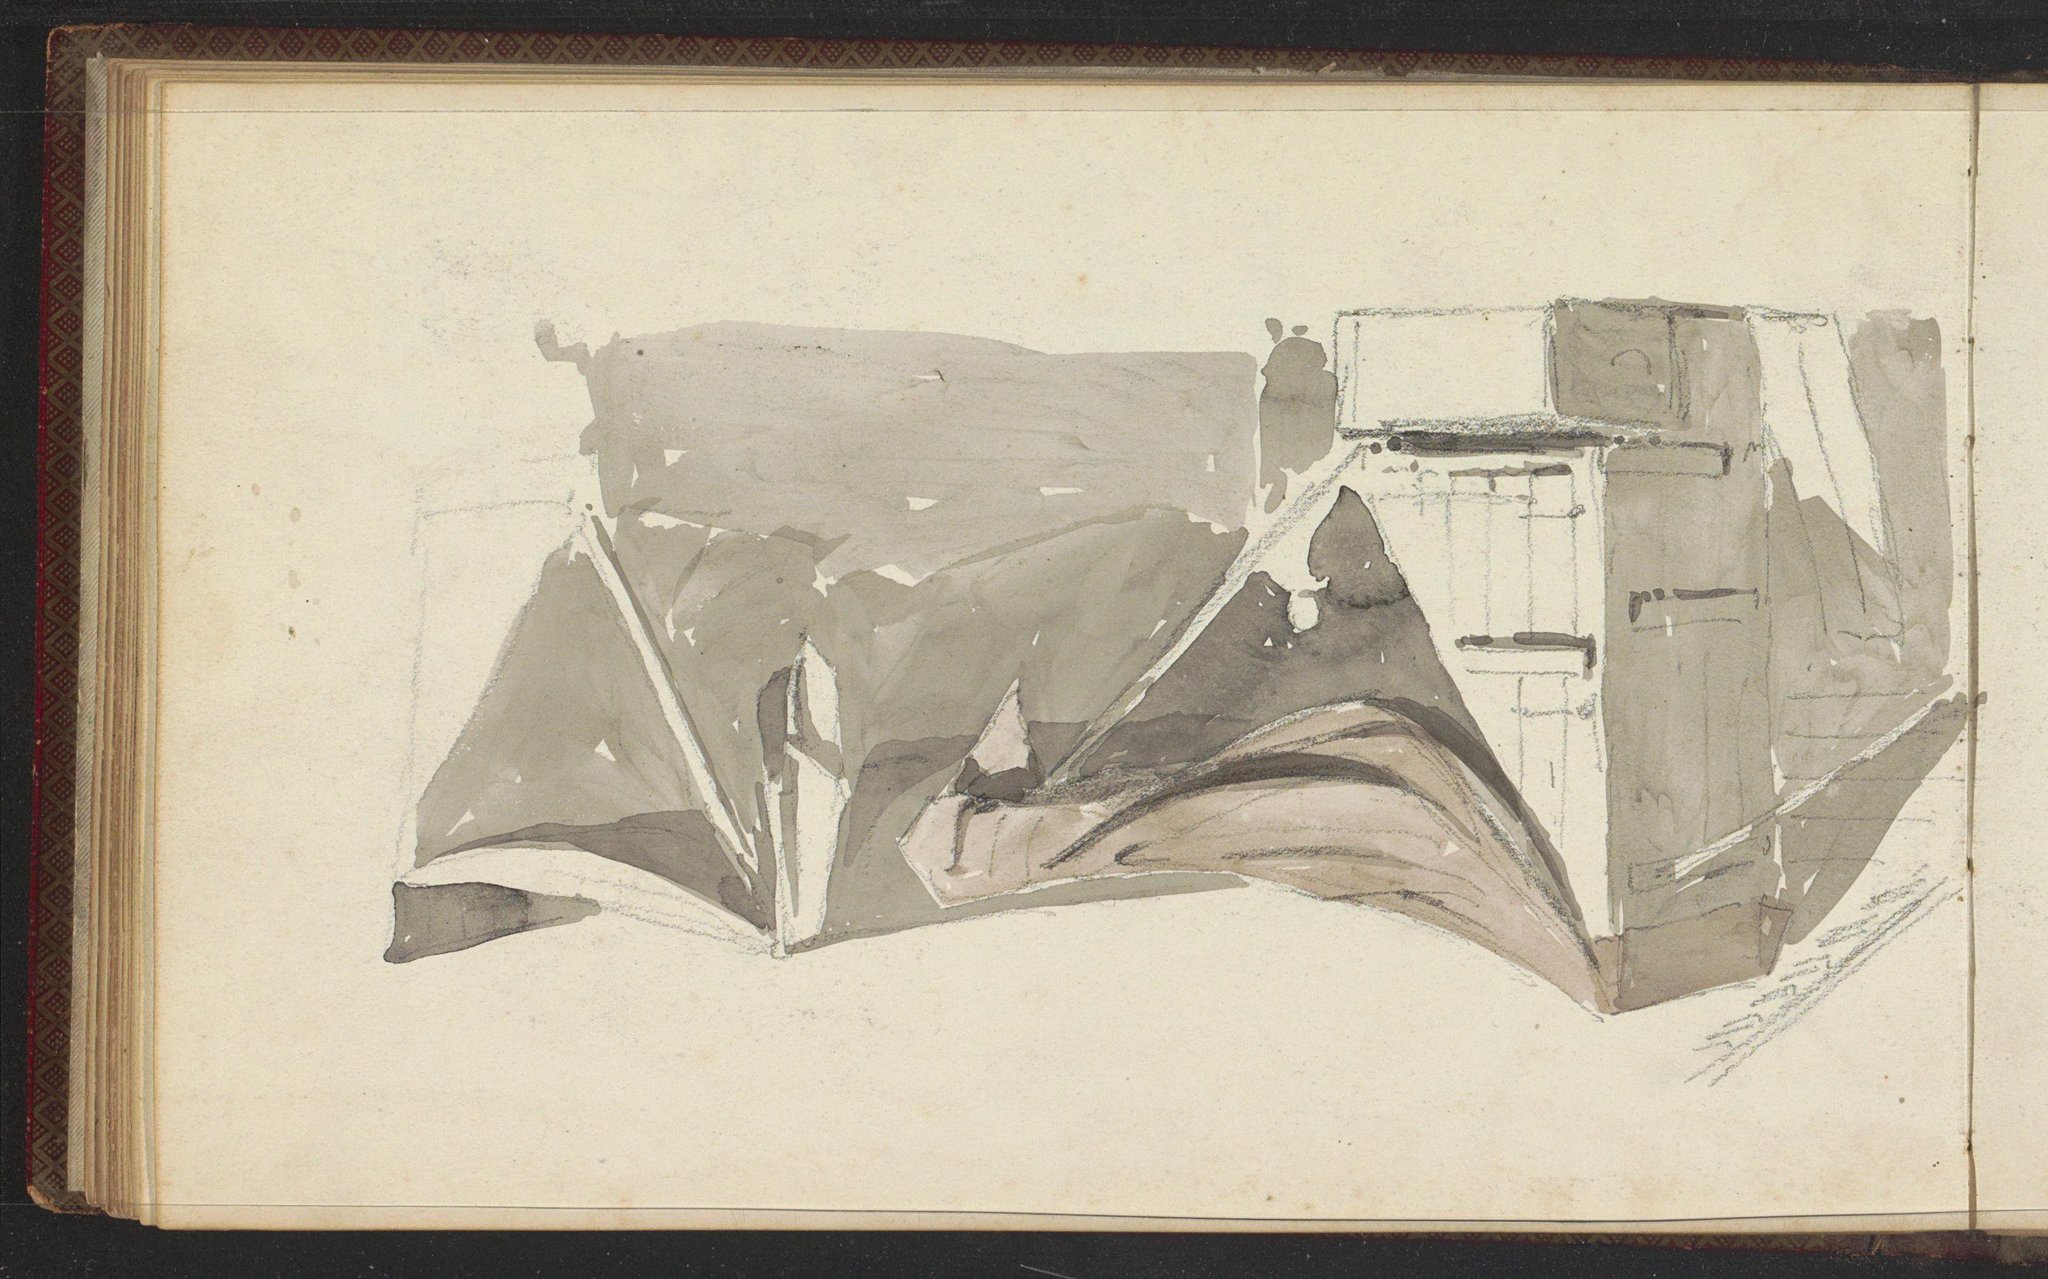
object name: sketchbook leaf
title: Twee marktkramen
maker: adrianus eversen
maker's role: draughtsman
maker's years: 1818-1897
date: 1828-1897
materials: paper, pencil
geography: netherlands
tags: stall, booth (~ market)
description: Twee marktkramen tegenover elkaar. Blad 34A verso uit een schetsboek met 52 bladen vervaardigd in de omgeving van Kampen, Hattem, Hoorn en Zwolle.